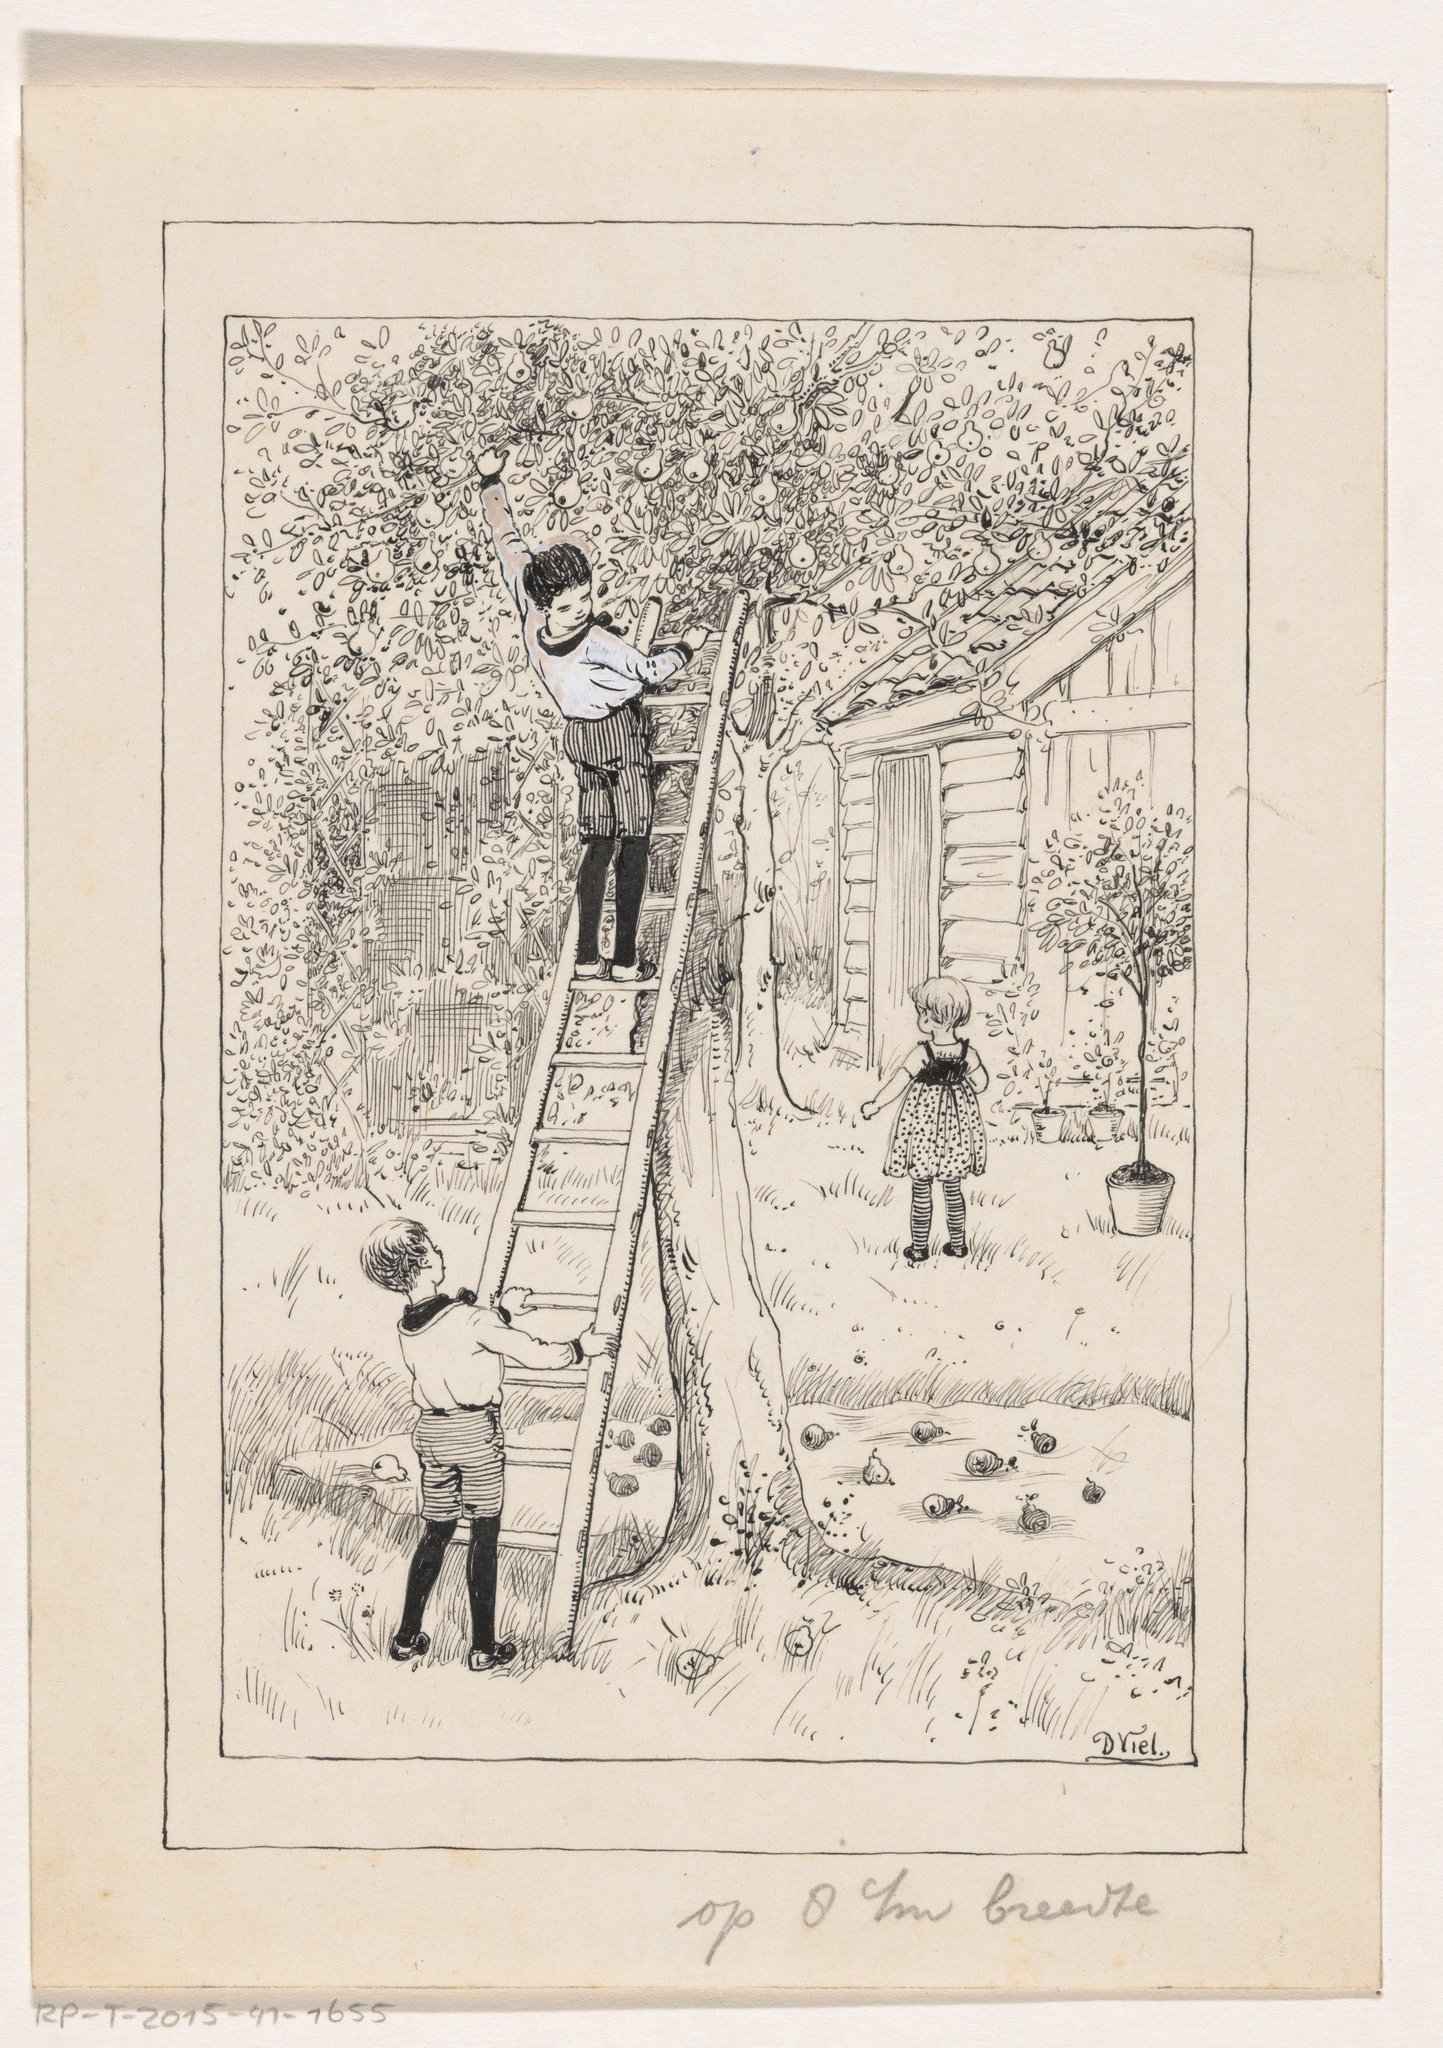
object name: drawing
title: Twee jongens plukken peren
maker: d. viel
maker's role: draughtsman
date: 1915-1935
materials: paint, ink, paper, pencil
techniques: brush, pen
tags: fruits: pear, orchard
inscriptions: signature: ‘D Viel.’, :, collector's mark: Lugt 2228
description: In een tuin houdt een jongen een ladder vast die tegen de stam van een perenboom leunt. Bovenaan de ladder staat een jongen die peren plukt. Op de grond rond de boom liggen peren. In de tuin staat een meisje.